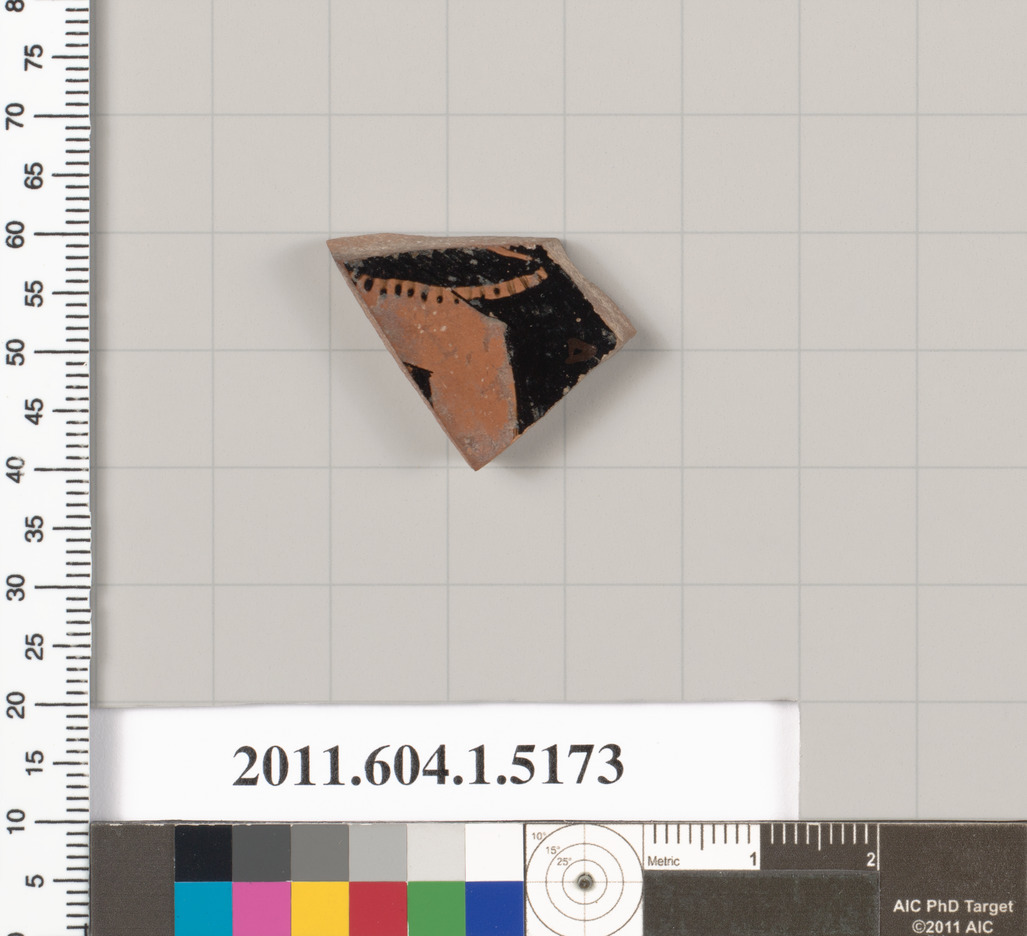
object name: kylix fragment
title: Terracotta fragment of a kylix (drinking cup)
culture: greek, attic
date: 500-480 BCE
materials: terracotta